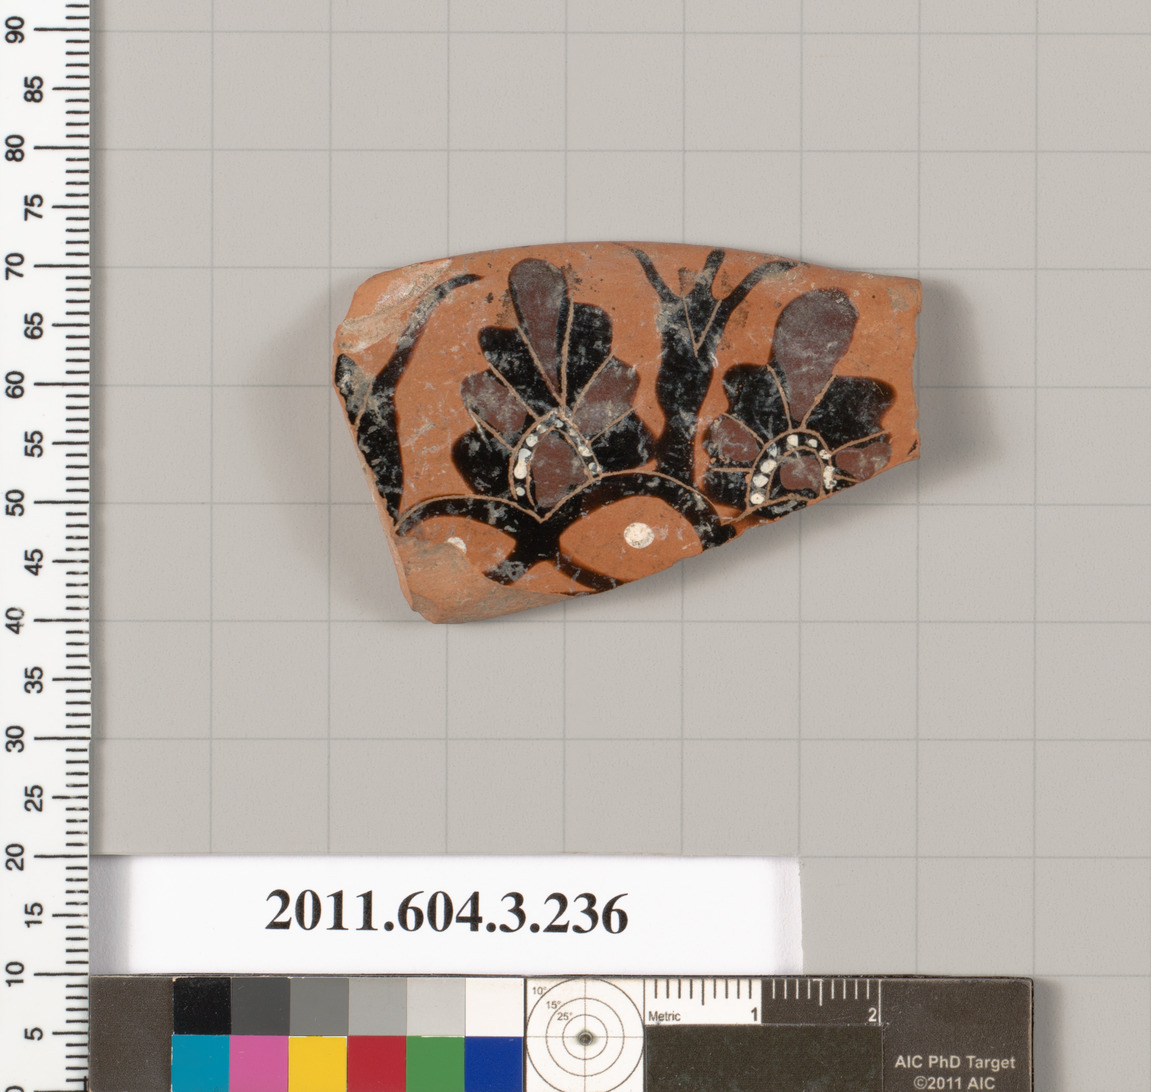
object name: neck amphora fragment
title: Terracotta fragment of a neck-amphora of Nicosthenic shape (jar)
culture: greek, attic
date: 534-468 BCE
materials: terracotta